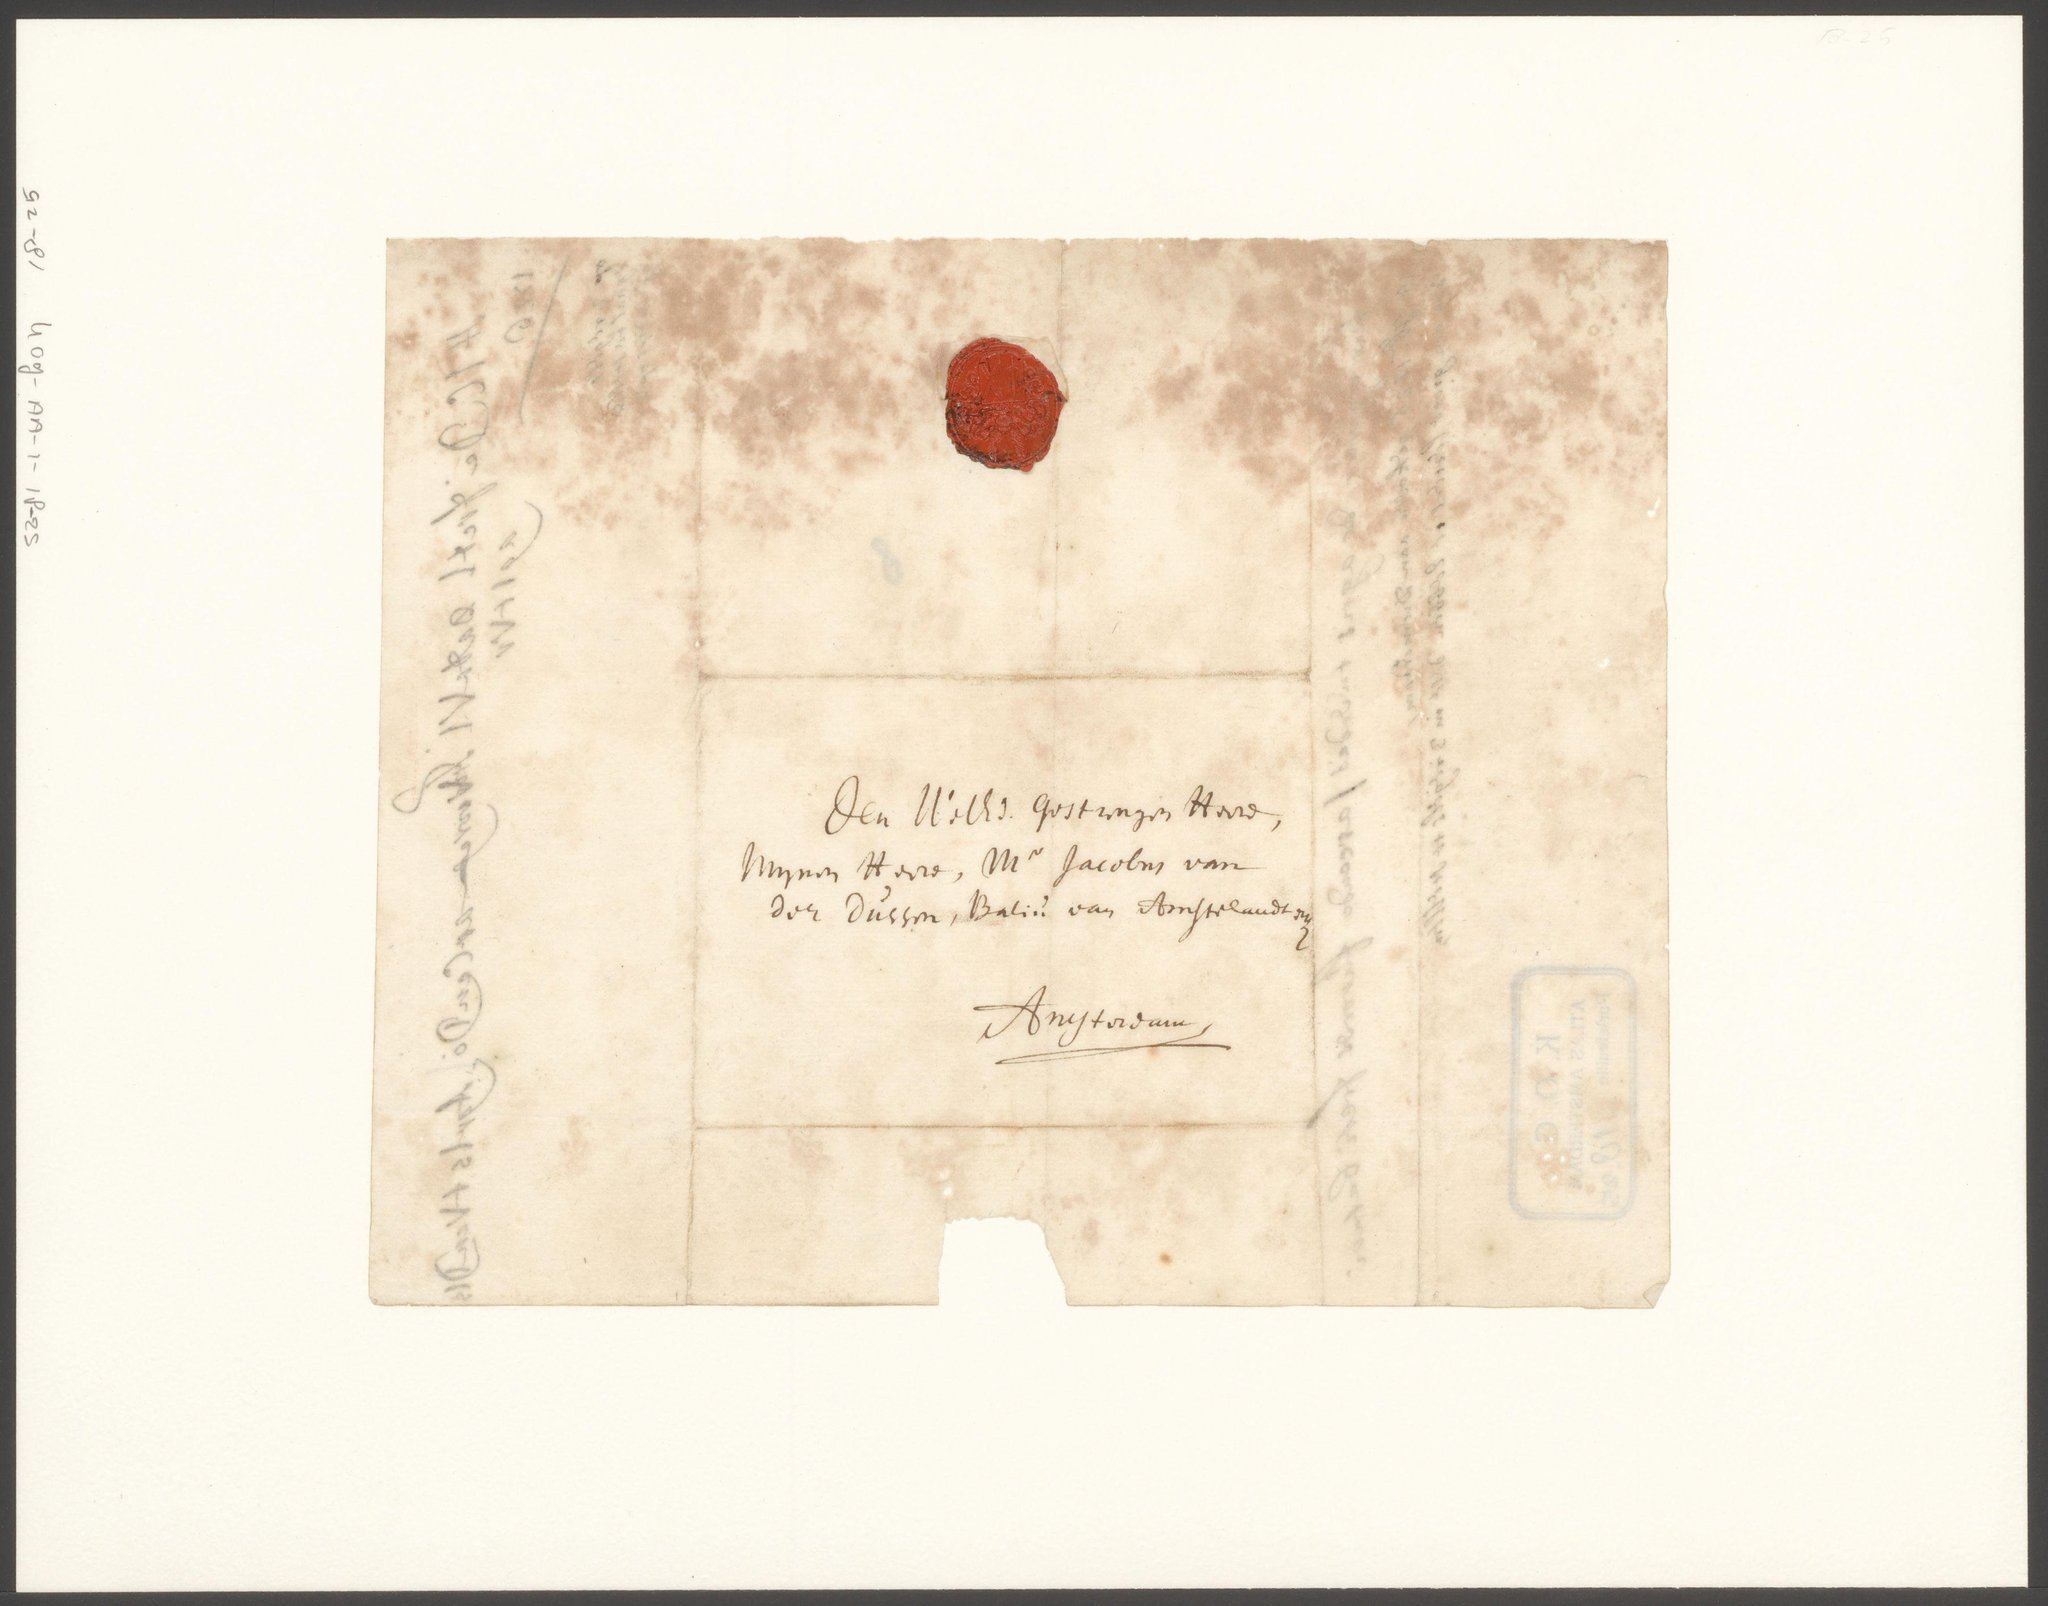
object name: letter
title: Brief aan baljuw Jacobus van der Dussen, mogelijk over een tekst te plaatsen bij een buitenplaats te Diemerdam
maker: Anonymous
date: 1726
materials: ink, paper, wax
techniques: pen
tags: handwriting, written text, amsterdam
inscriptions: collector's mark: ‘18.25’ Lugt 1641b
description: Onderwerpsrubriek binnen de Atlas Amsterdam: Herinneringen aan regeringsleden en hunne huisgezinnen [voor 1800].